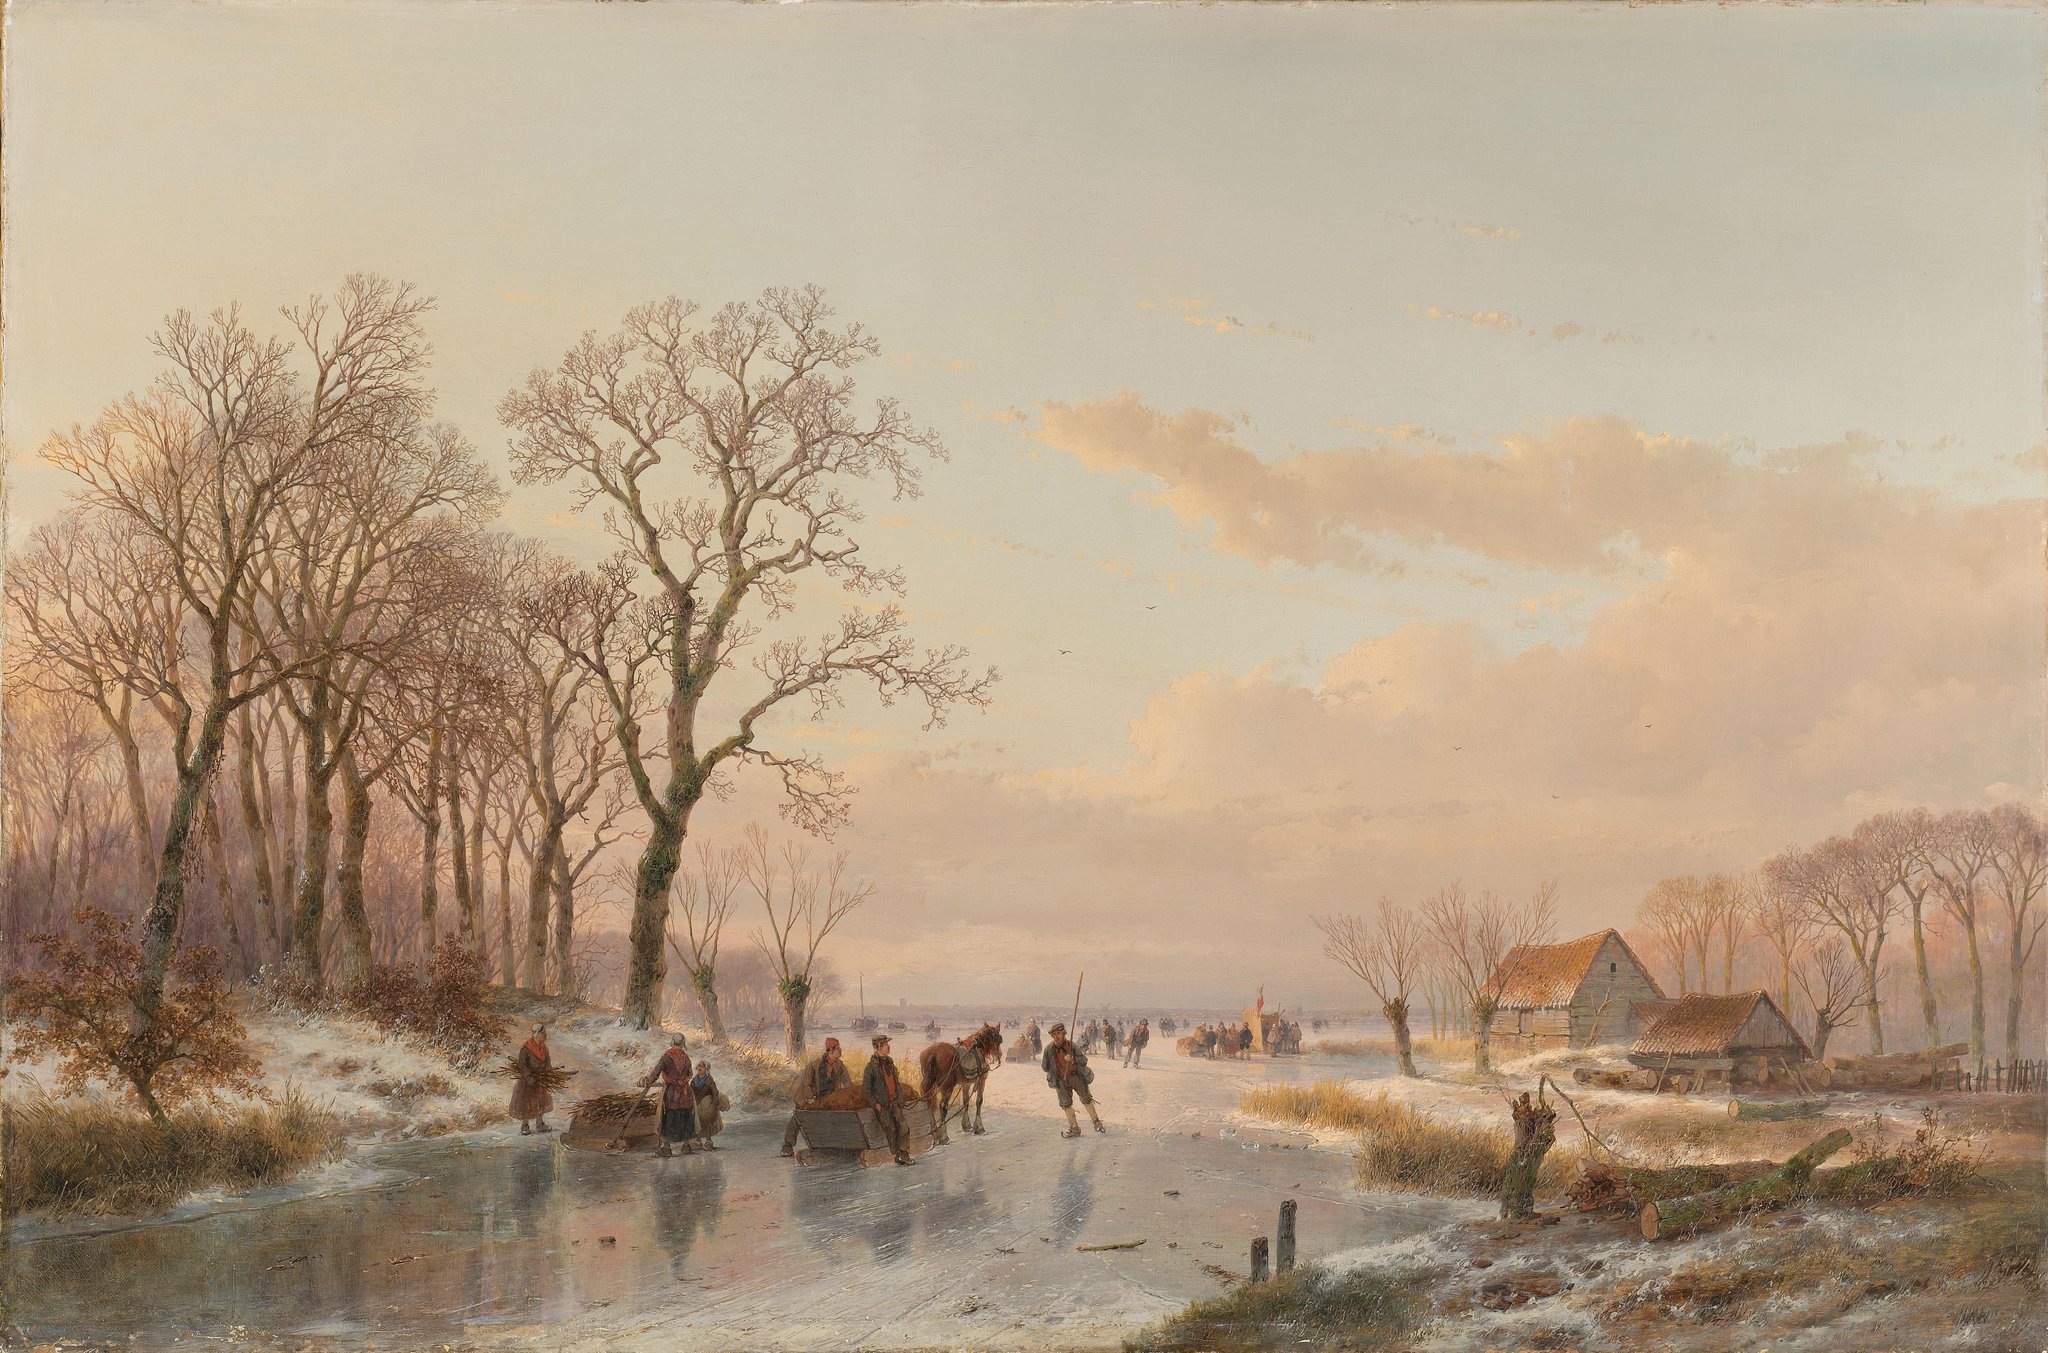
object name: painting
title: A frozen waterway near the Maas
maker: andreas schelfhout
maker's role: draughtsman, painter, print maker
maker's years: 1787-1870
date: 1867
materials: canvas, oil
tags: water course, skates (winter sports)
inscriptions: signature: ‘A. Schelfhout’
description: This winter landscape presents a typically Dutch river scene: a panoramic, tranquil world almost devoid of colour. The activity on the ice creates a cheerful accent. Schelfhout specialized in this genre. His frozen winter scenes, which allude to the 17th century, were extremely popular. They were even called ‘little Schelfhouts’.